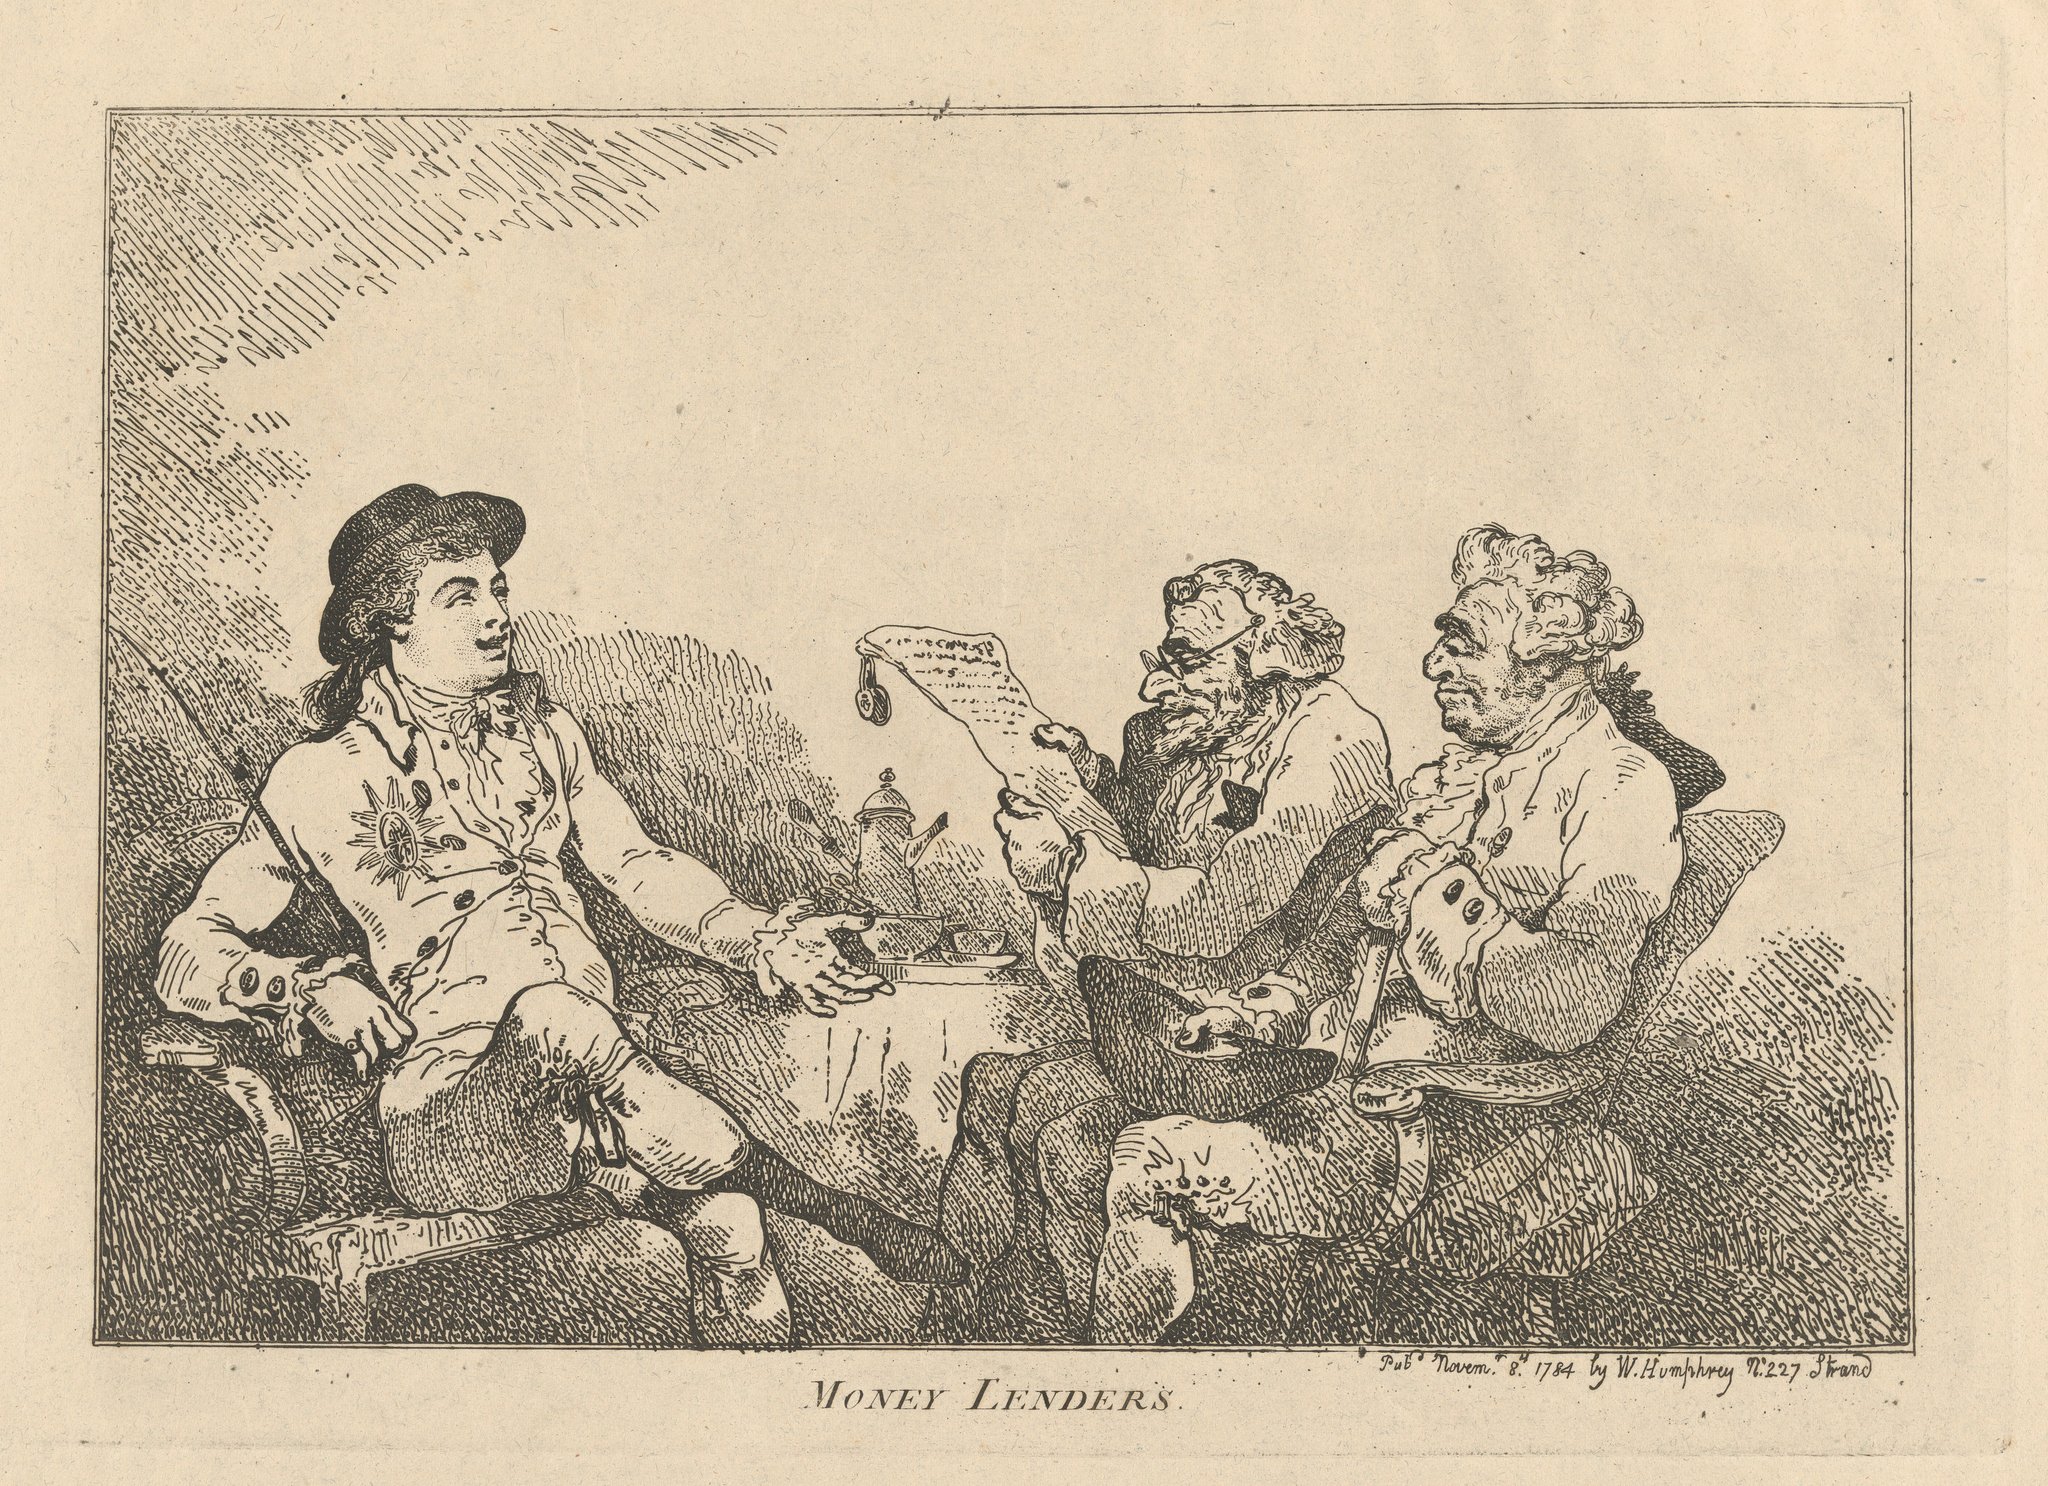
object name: print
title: Money Lenders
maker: thomas rowlandson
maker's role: artist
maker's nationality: british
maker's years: 1757-1827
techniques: etching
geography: london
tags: men,reading